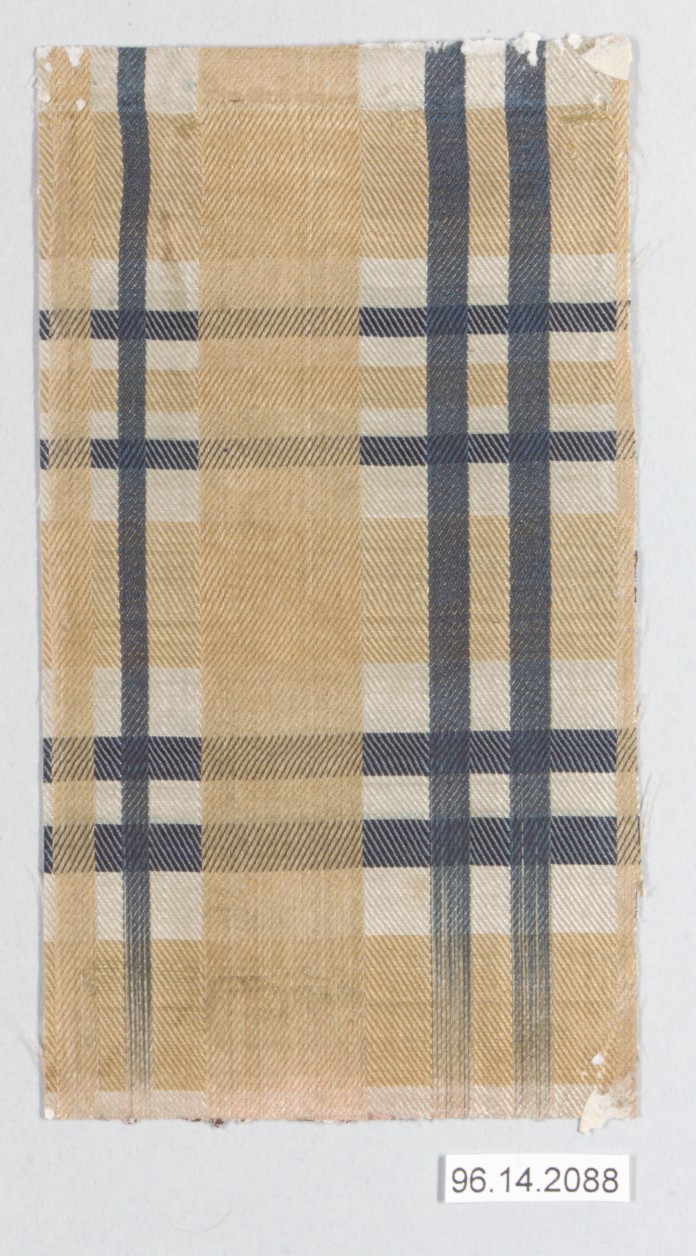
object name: piece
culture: japanese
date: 1701-1900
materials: silk